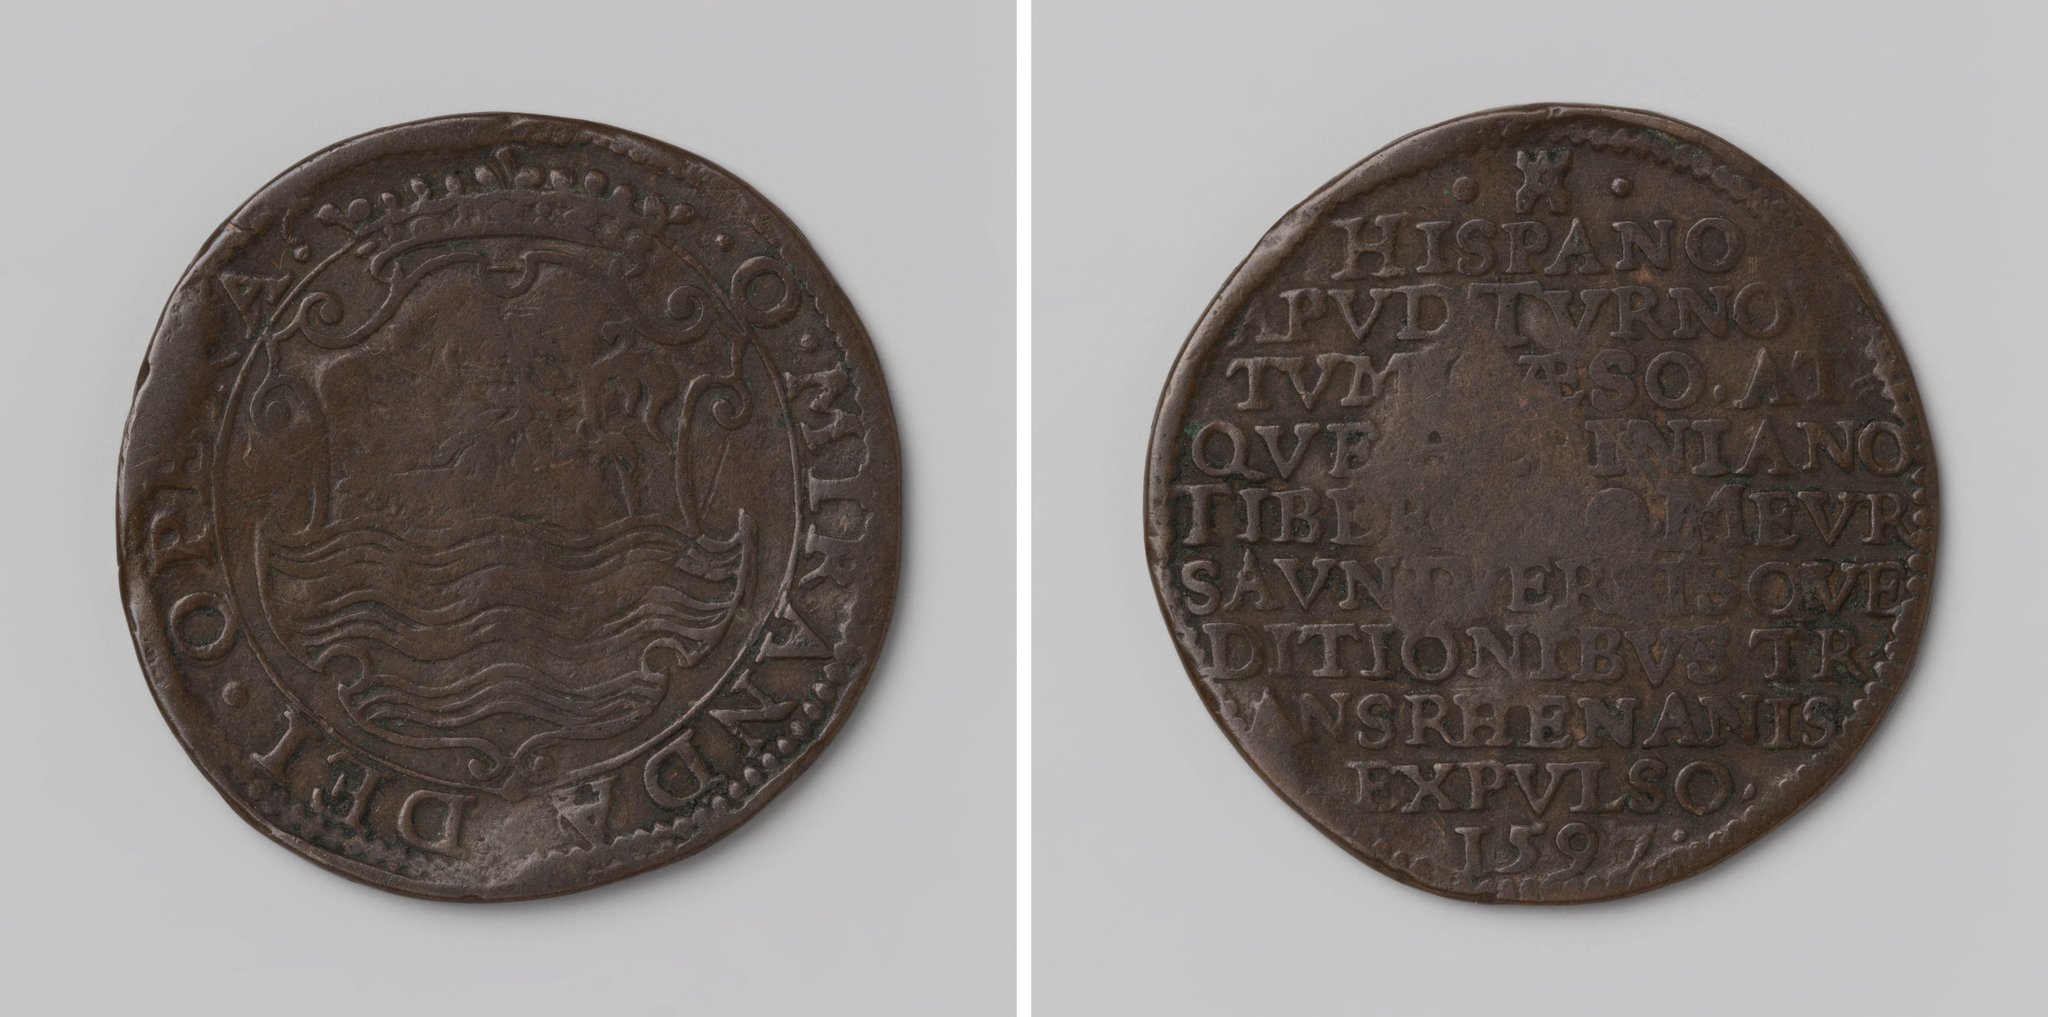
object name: jeton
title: Overwinning in de slag bij Turnhout en het verdrijven van de Spanjaarden uit Alpen, Moers en het Rijngebied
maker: Anonymous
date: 1597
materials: copper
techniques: striking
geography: middelburg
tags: zeeland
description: Koperen penning. Voorzijde: gekroond wapenschild in cartouche binnen omschrift. Keerzijde: opschrift